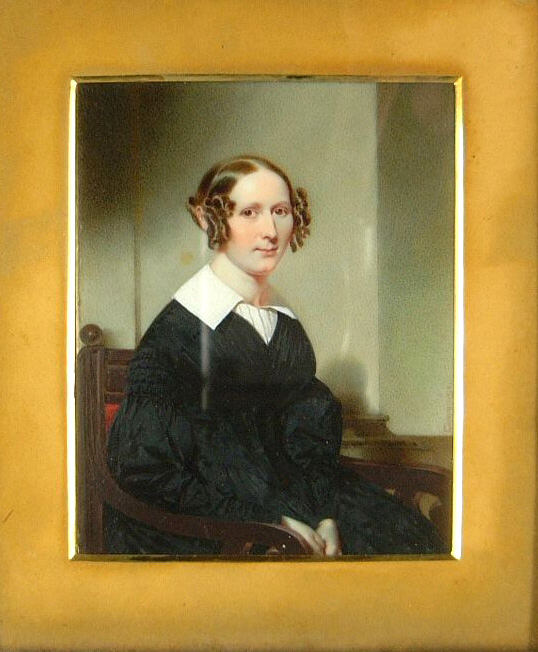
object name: painting, miniature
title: Mrs. Oswald John Cammann (Catherine Navarre Macomb)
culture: american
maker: thomas seir cummings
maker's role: artist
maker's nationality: american, born england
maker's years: 1804-1894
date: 1843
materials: ivory, watercolor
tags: portraits,women